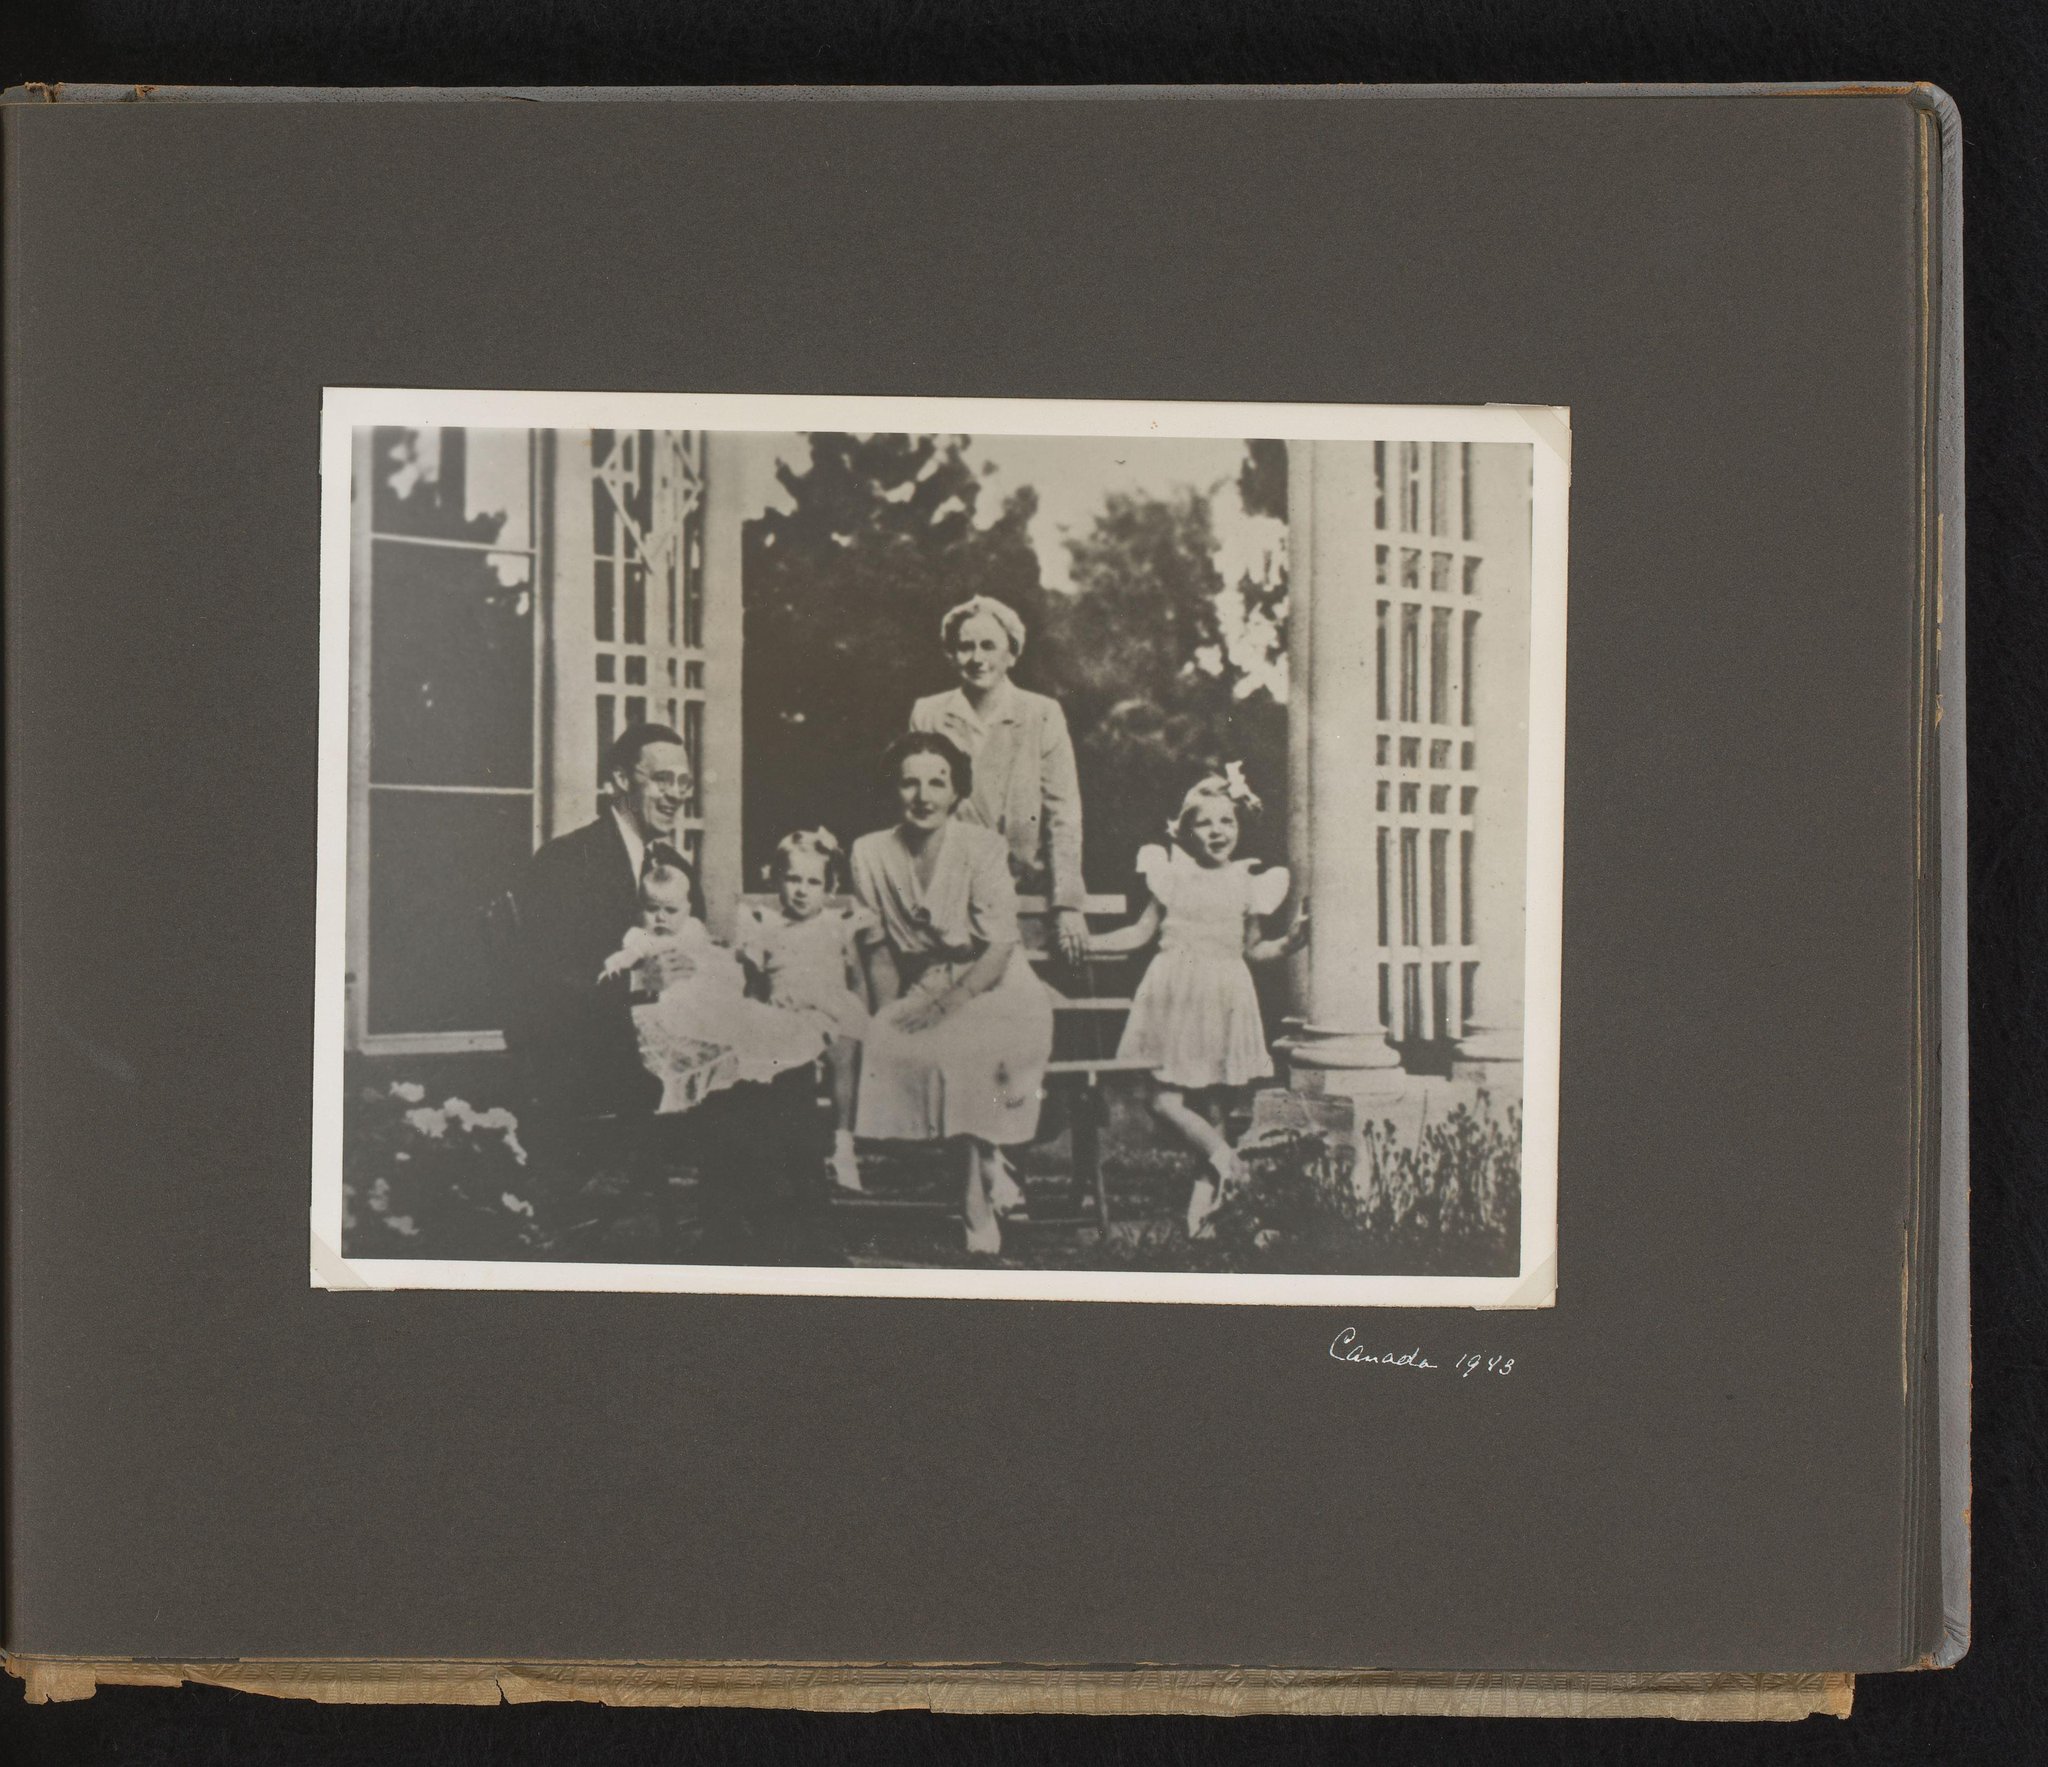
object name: photograph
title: Koninklijke Familie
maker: Anonymous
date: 1943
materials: cardboard, photographic support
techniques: gelatin silver print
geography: canada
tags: utrecht, bernhard (prins der nederlanden), beatrix (koningin der nederlanden), juliana of the netherlands, parents with their children, canada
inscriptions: inscription: ‘Canada 1943’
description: Albumblad met een foto van de Koninklijke Familie in Canada, 1943. Onderdeel van fotoalbum over het familieleven van de leden van het Koninklijk Huis tussen 1937-1945.